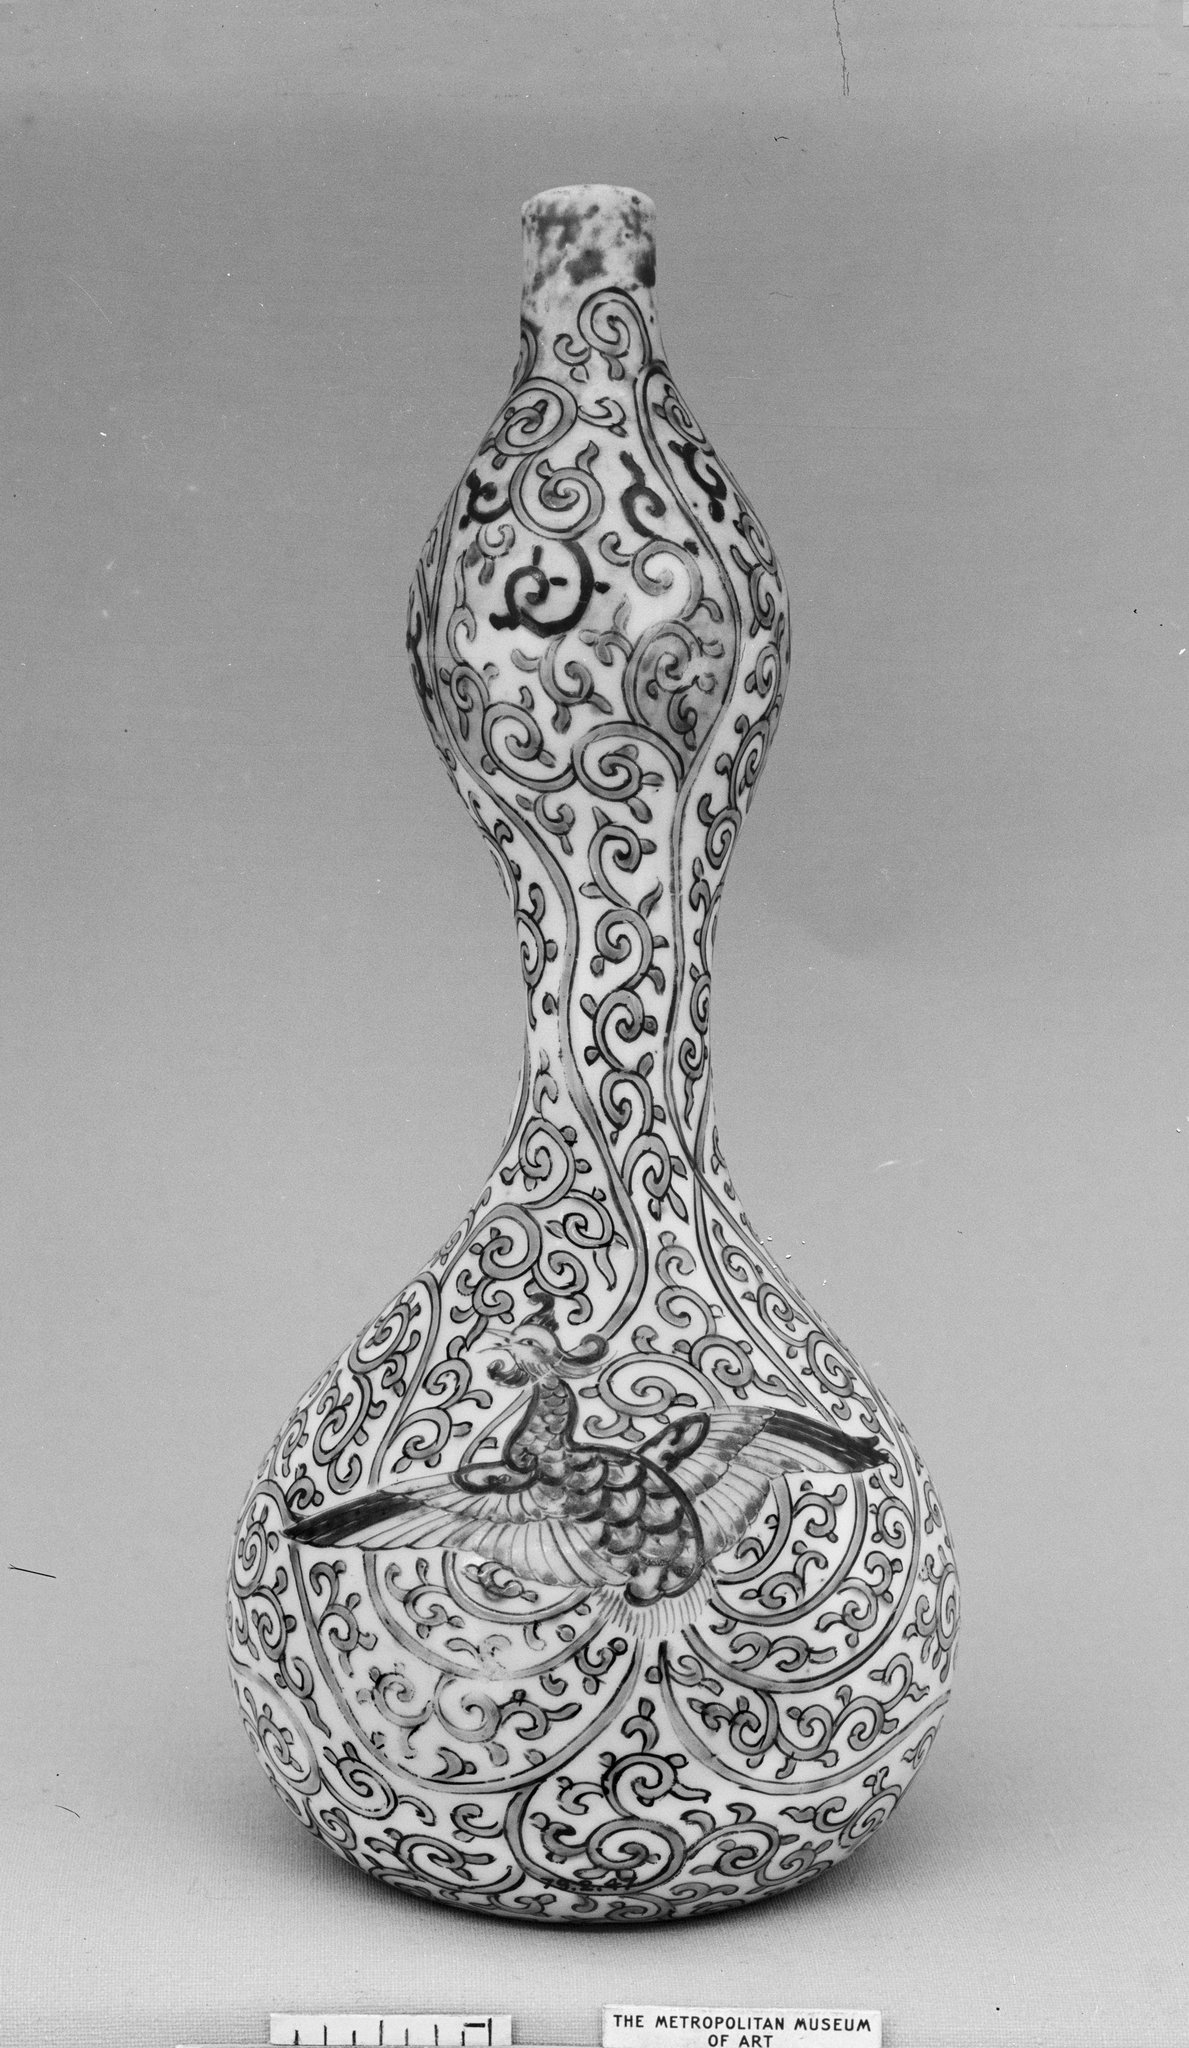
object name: bottle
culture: japanese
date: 1701-1800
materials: enamel, iron, porcelain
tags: birds